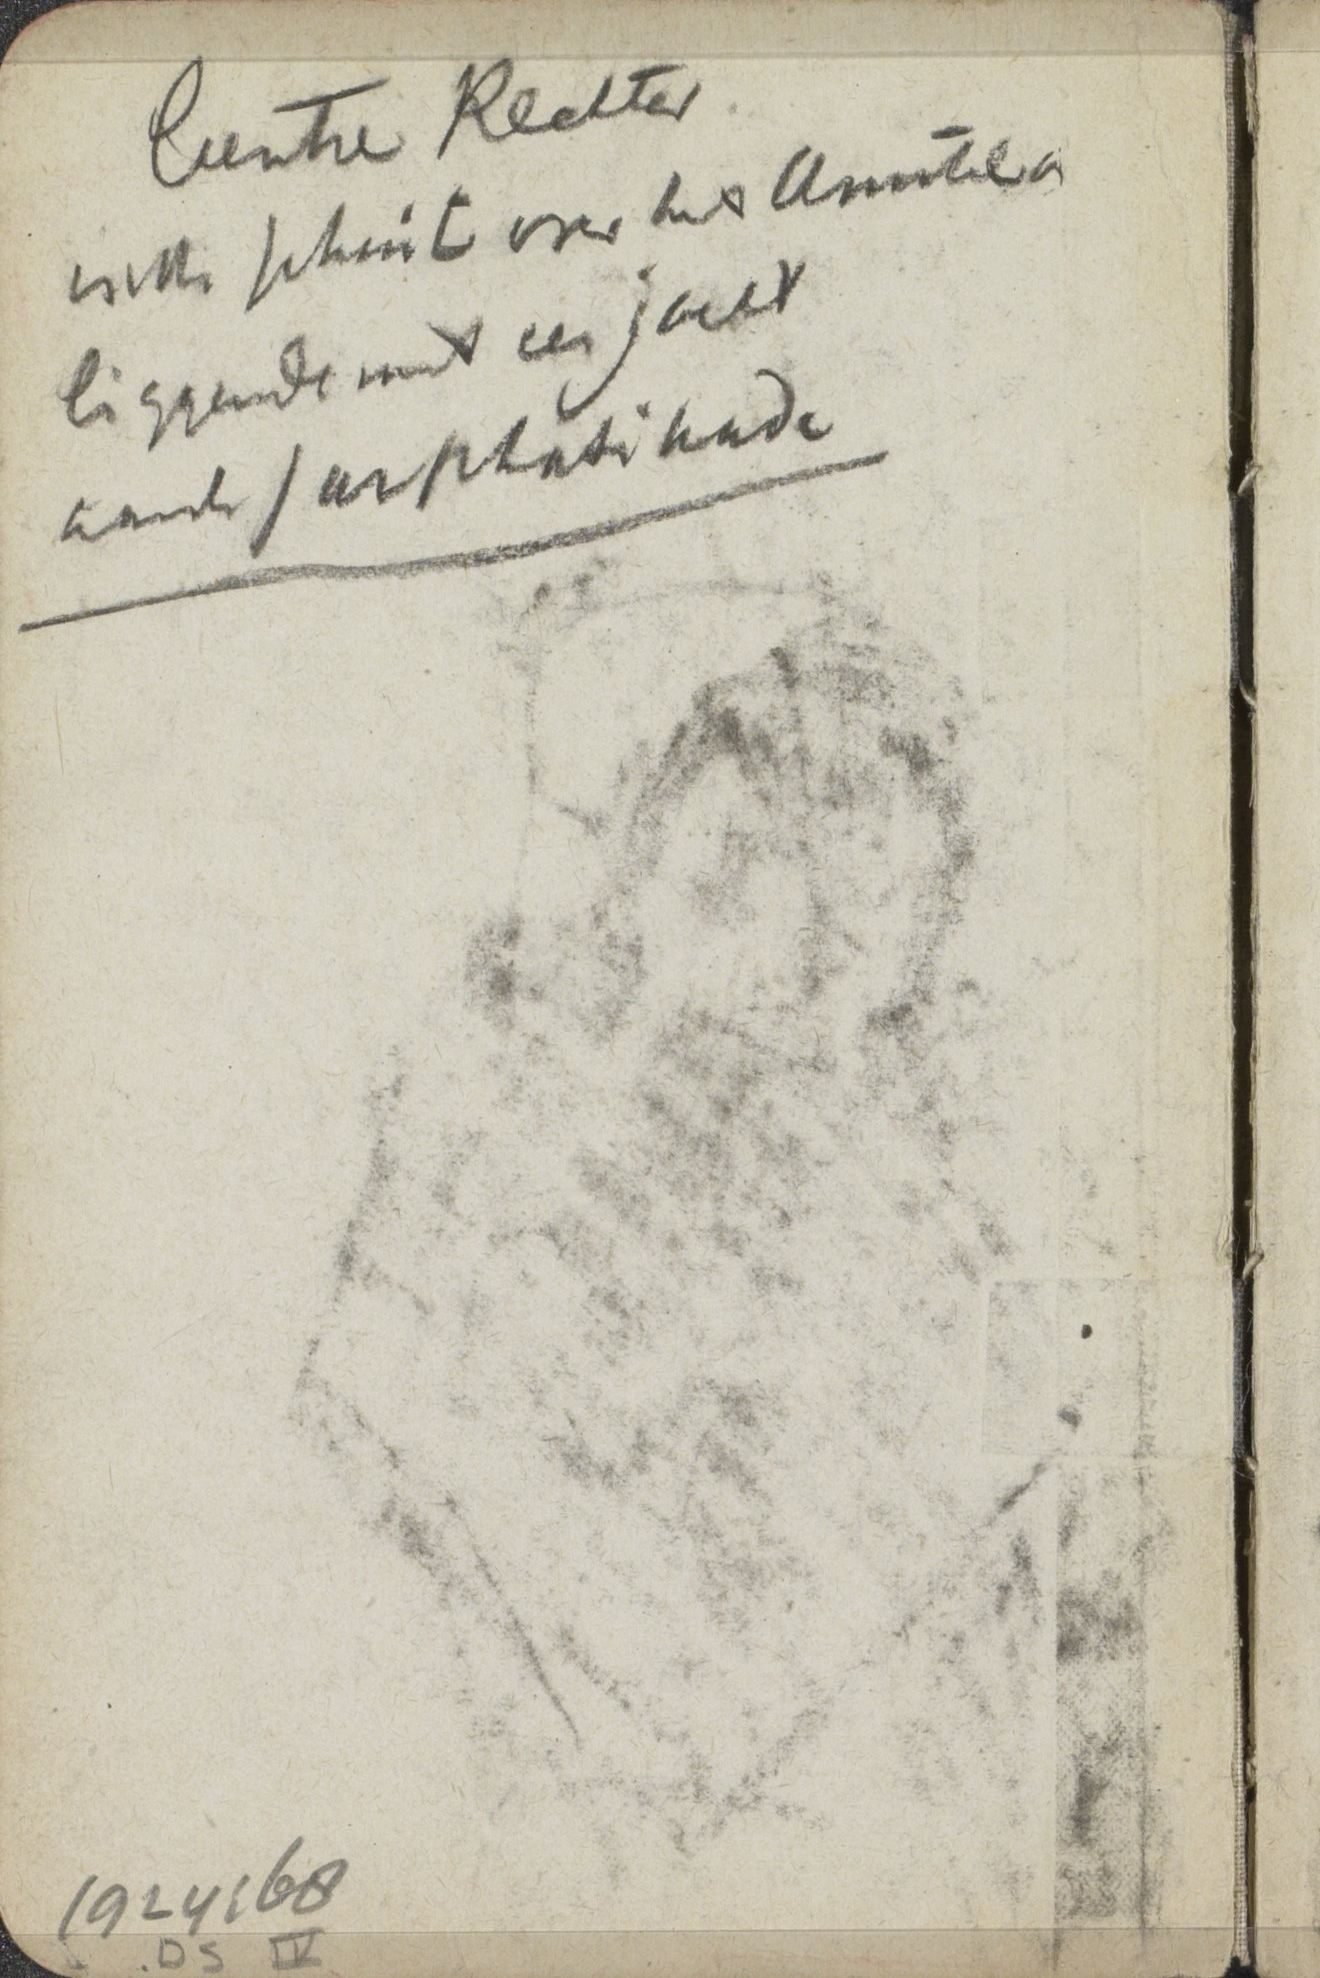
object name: endleaf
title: Annotaties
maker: george hendrik breitner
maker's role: draughtsman, painter, print maker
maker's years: 1857-1923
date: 1893-1898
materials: chalk, paper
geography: amsterdam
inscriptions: annotation: ‘Lientje Rechter/ is[...] schuit over het [...]/ liggende met een jacht/ aan de Sarphatikade’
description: Pagina 1, voorste schutblad, uit een schetsboek met 38 bladen.